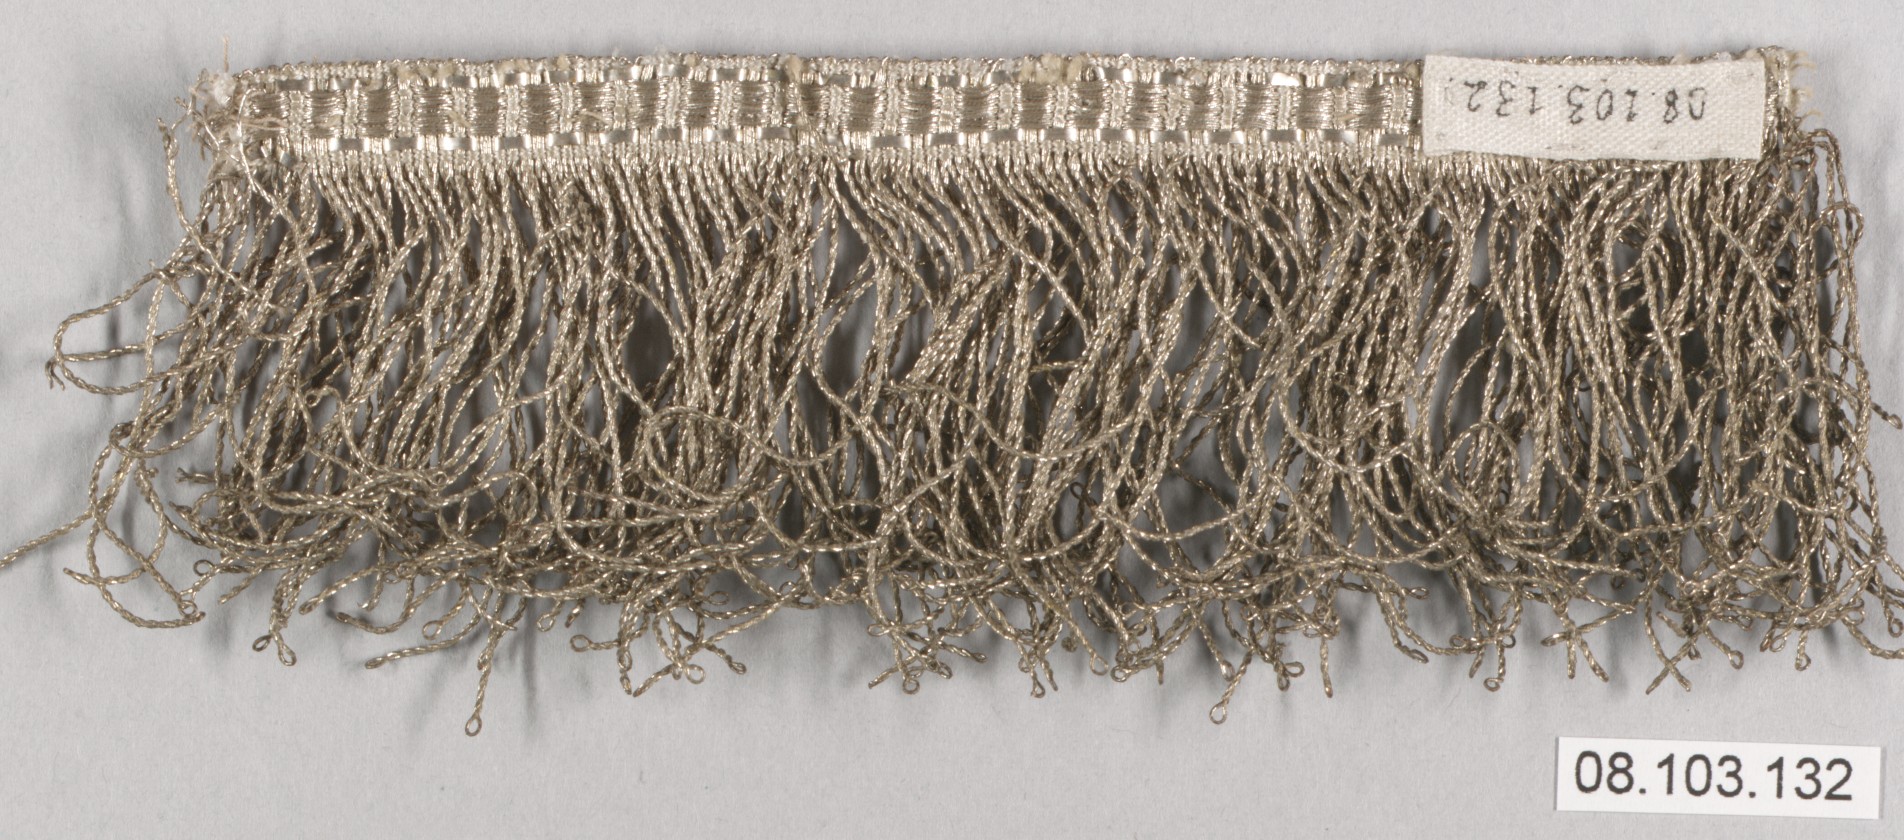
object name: fringe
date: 1801-1833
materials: metal thread